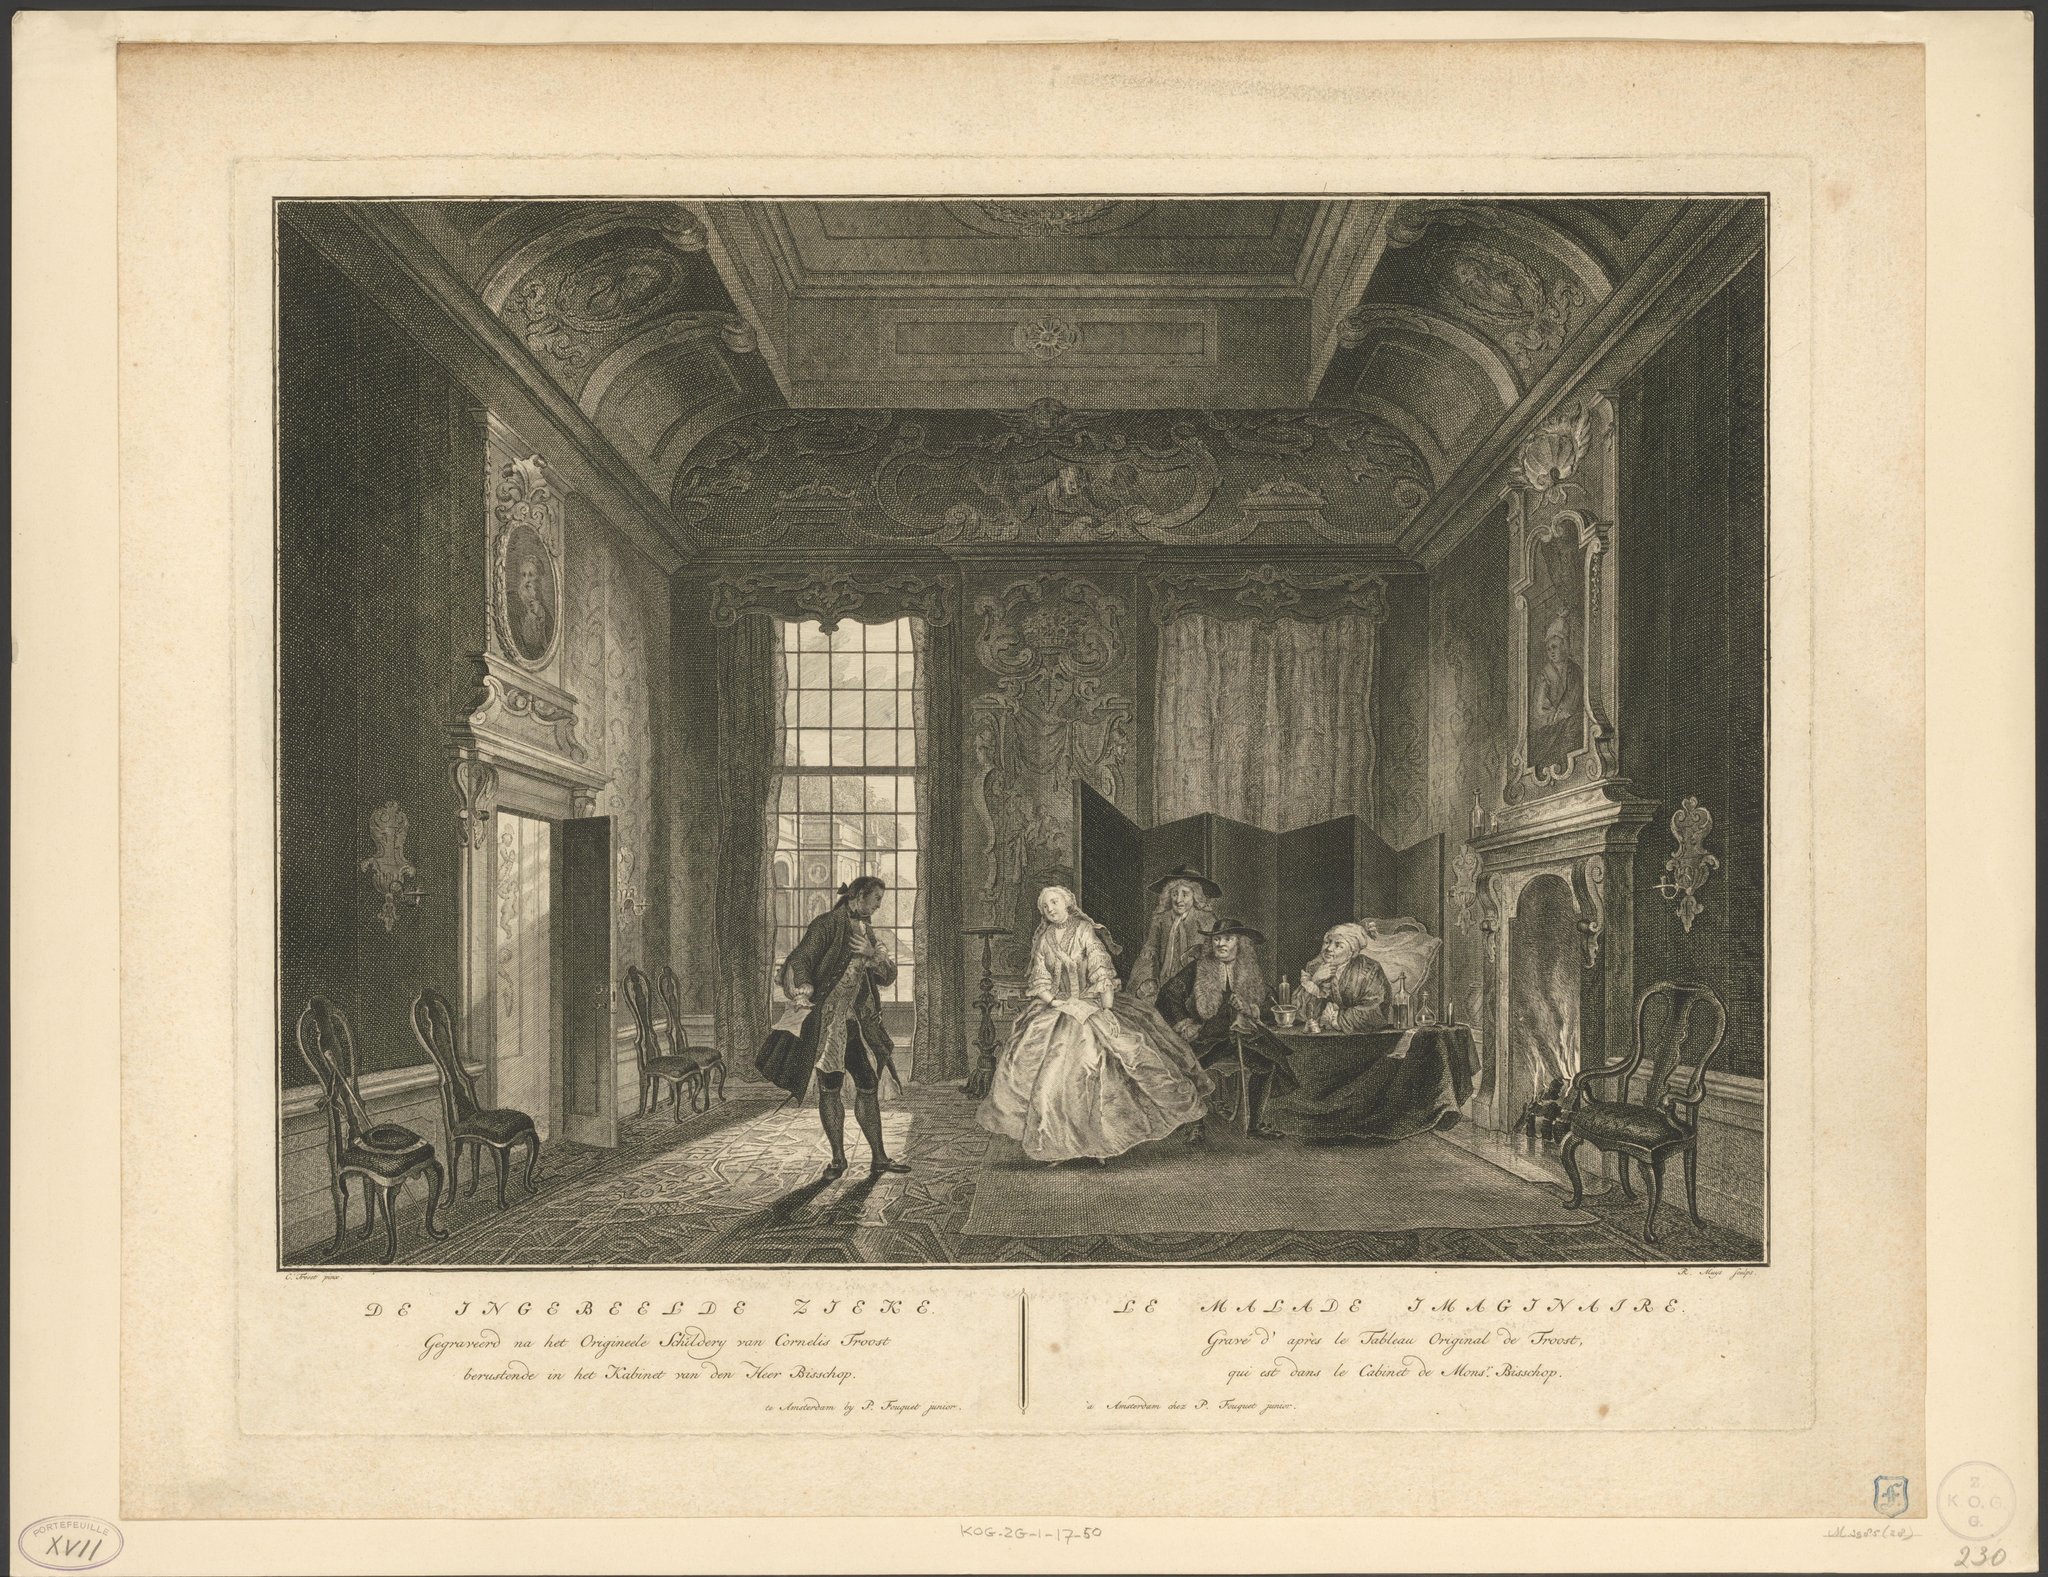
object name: print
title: De ingebeelde zieke / Le malade imaginaire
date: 1752-1800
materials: paper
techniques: engraving, etching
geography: amsterdam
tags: hypochondriac, pharmacist, druggist, apothecary; pharmacy, drugstore, dispensing chemist, container of glass: bottle, jar, vase, meeting, living-room, parlour, sitting-room, comedy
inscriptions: collector's mark: Lugt 963, collector's mark: Lugt 1641, stamp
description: Helena en haar heimelijke minnaar Ferdinand dragen een herdersdicht aan elkaar voor, waarin de personages elkaar hun liefde betuigen. Aan tafel zitten Helena's vader Manshart (de ingebeelde zieke), en zijn arts Narticoforus. Achter de arts staat zijn zoon Bartrand, voor wie Manshart zijn dochter bestemd heeft. Scène uit het tweede bedrijf van het toneelstuk De ingebeelde zieke van Molière. Onderwerpsrubrieken binnen de Atlas Zeden en Gewoonten: Tooneel, Prenten van Cornelis Troost.